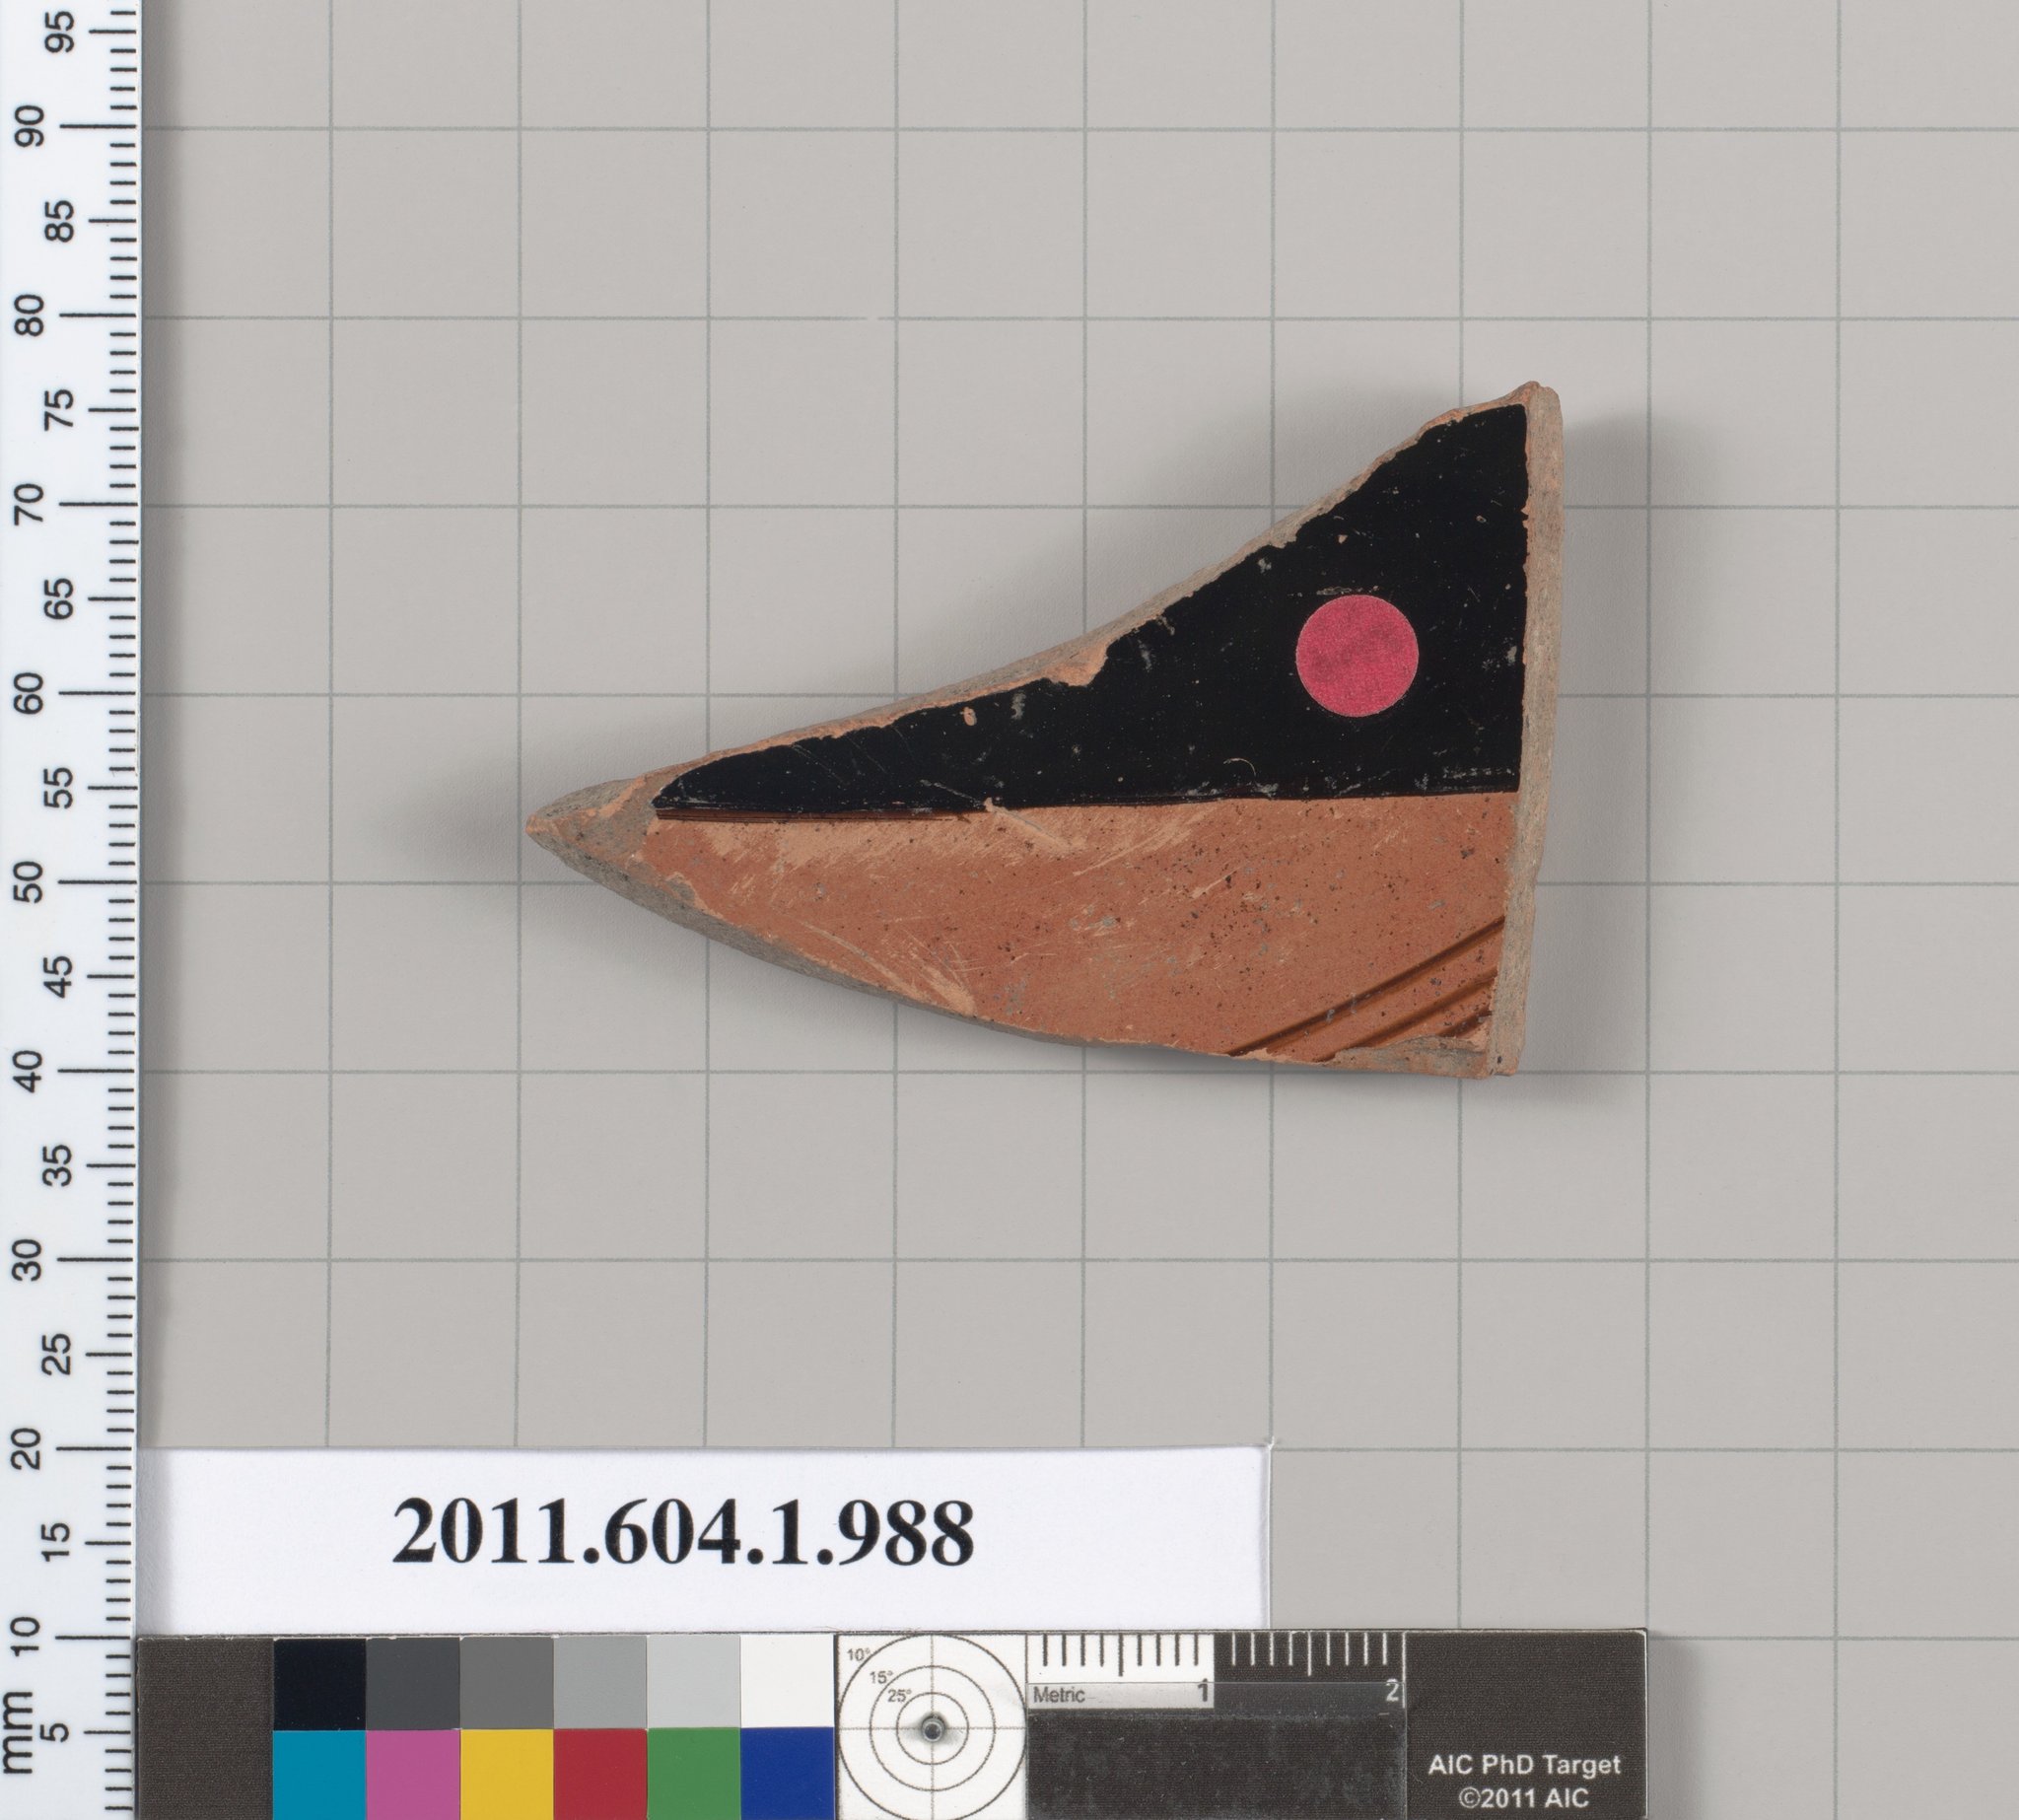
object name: kylix fragment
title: Terracotta fragment of a kylix (drinking cup)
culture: greek, attic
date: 475-451 BCE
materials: terracotta